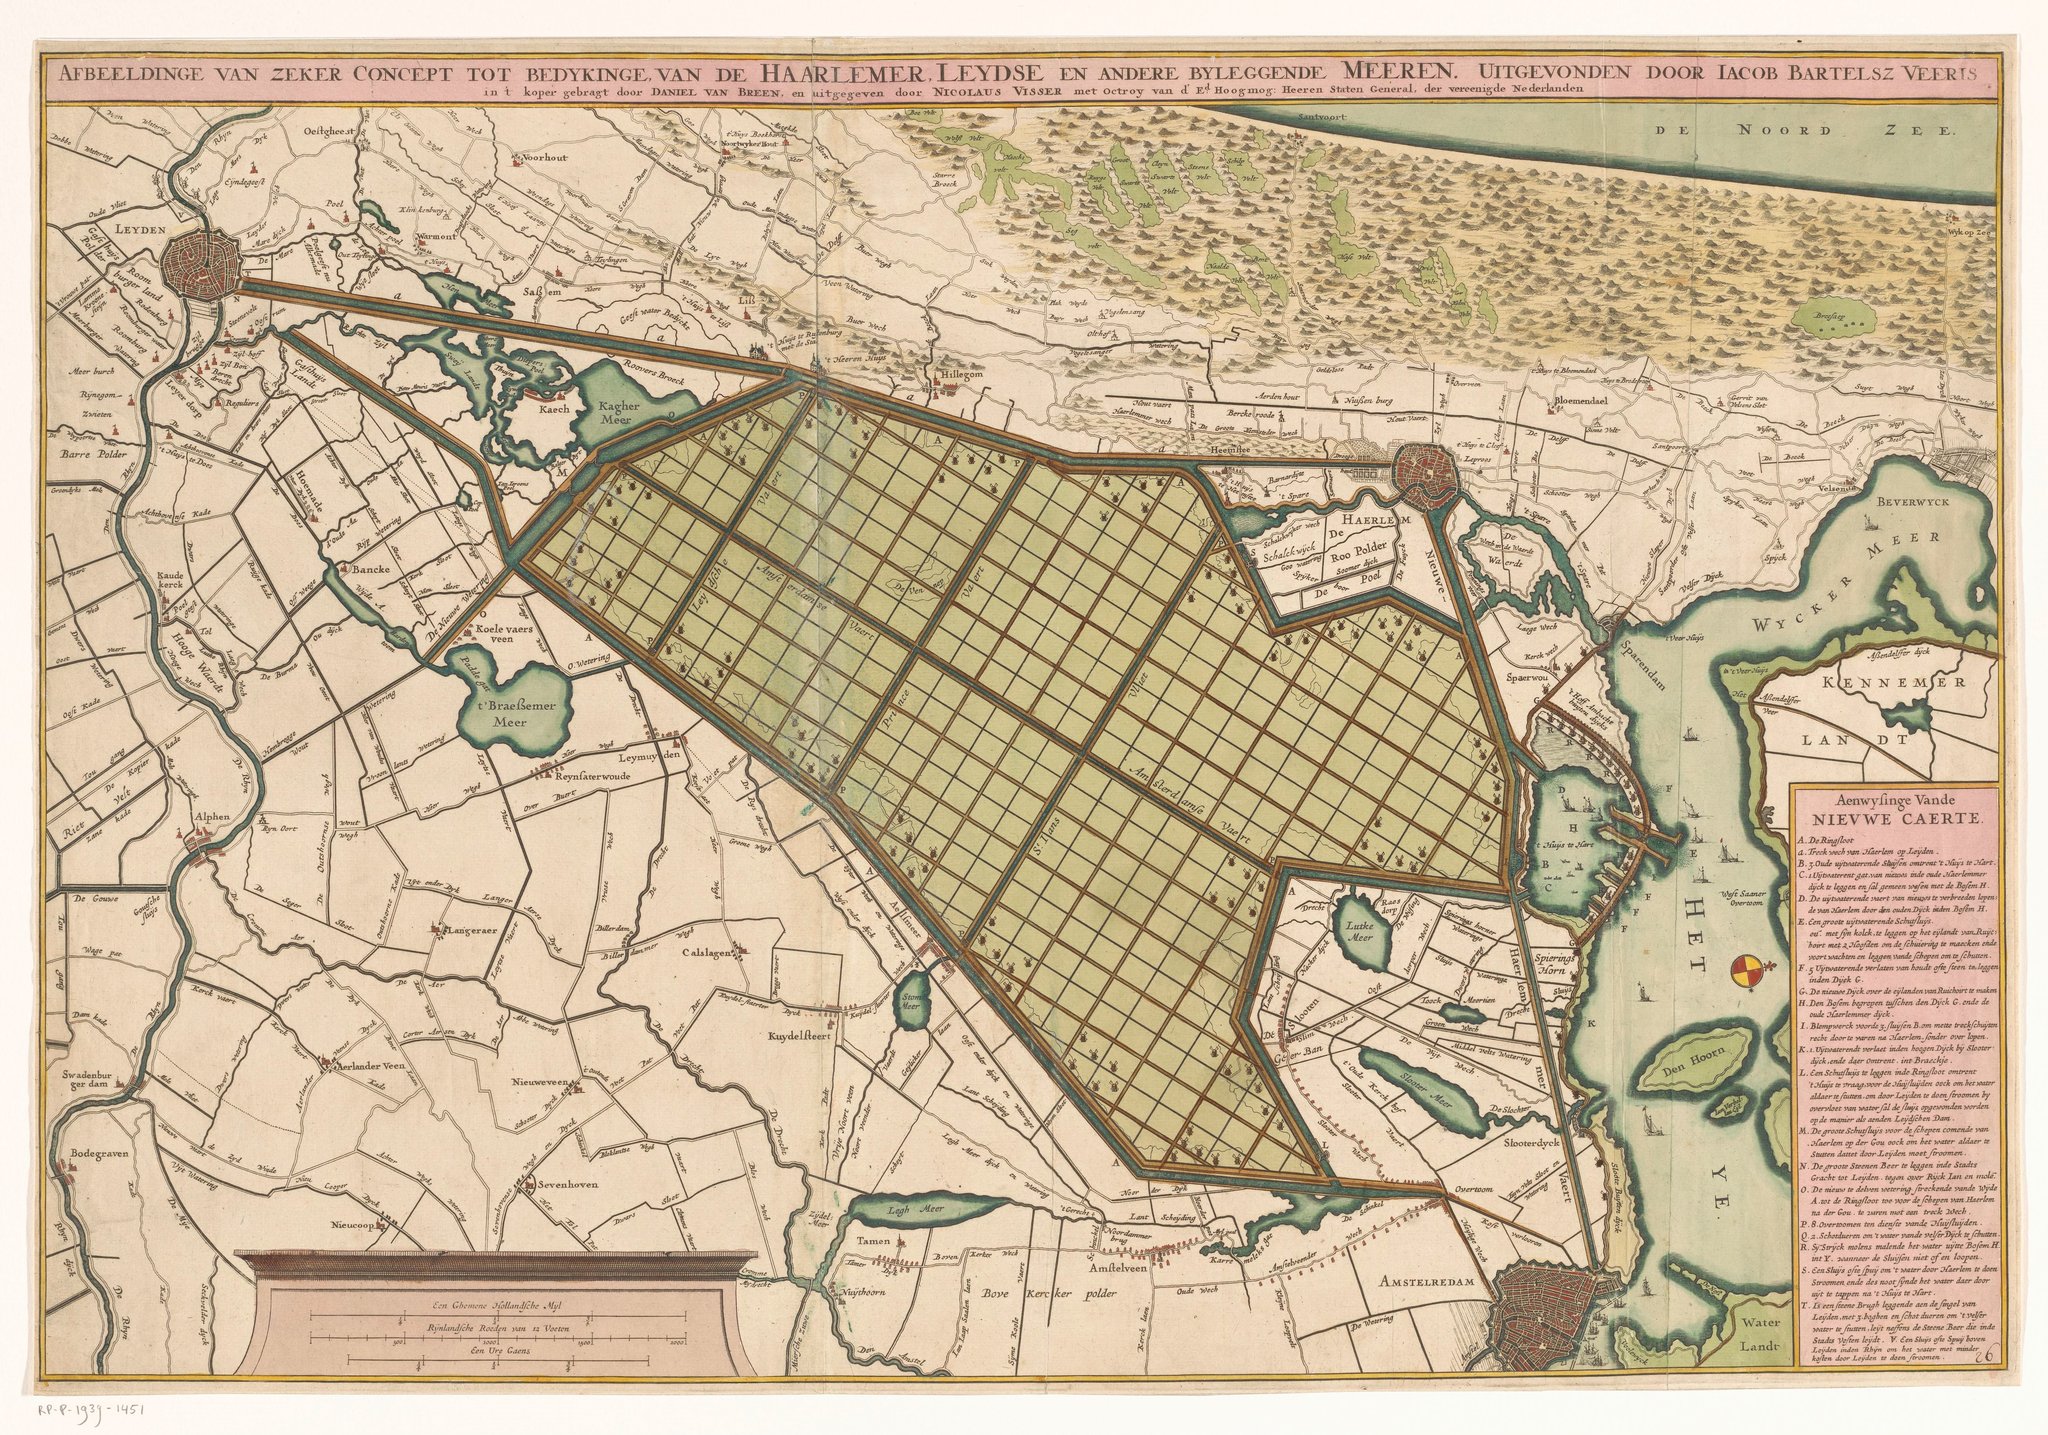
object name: print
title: Afbeeldinge van zeker concept tot bedykinge, van de Haarlemer, Leydse en andere byleggende meeren …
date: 1641-1665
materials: ink, paper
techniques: engraving, etching, hand coloring, pen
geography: amsterdam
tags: maps of separate countries or regions, polder, reclaimed land, maps of cities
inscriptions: collector's mark: Lugt 2166, collector's mark: Lugt 2760, inscription: ‘26’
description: Voor soortgelijke kaarten zie RP-P-AO-9-41, RP-P-AO-9-42 en RP-P-OB-81.622.